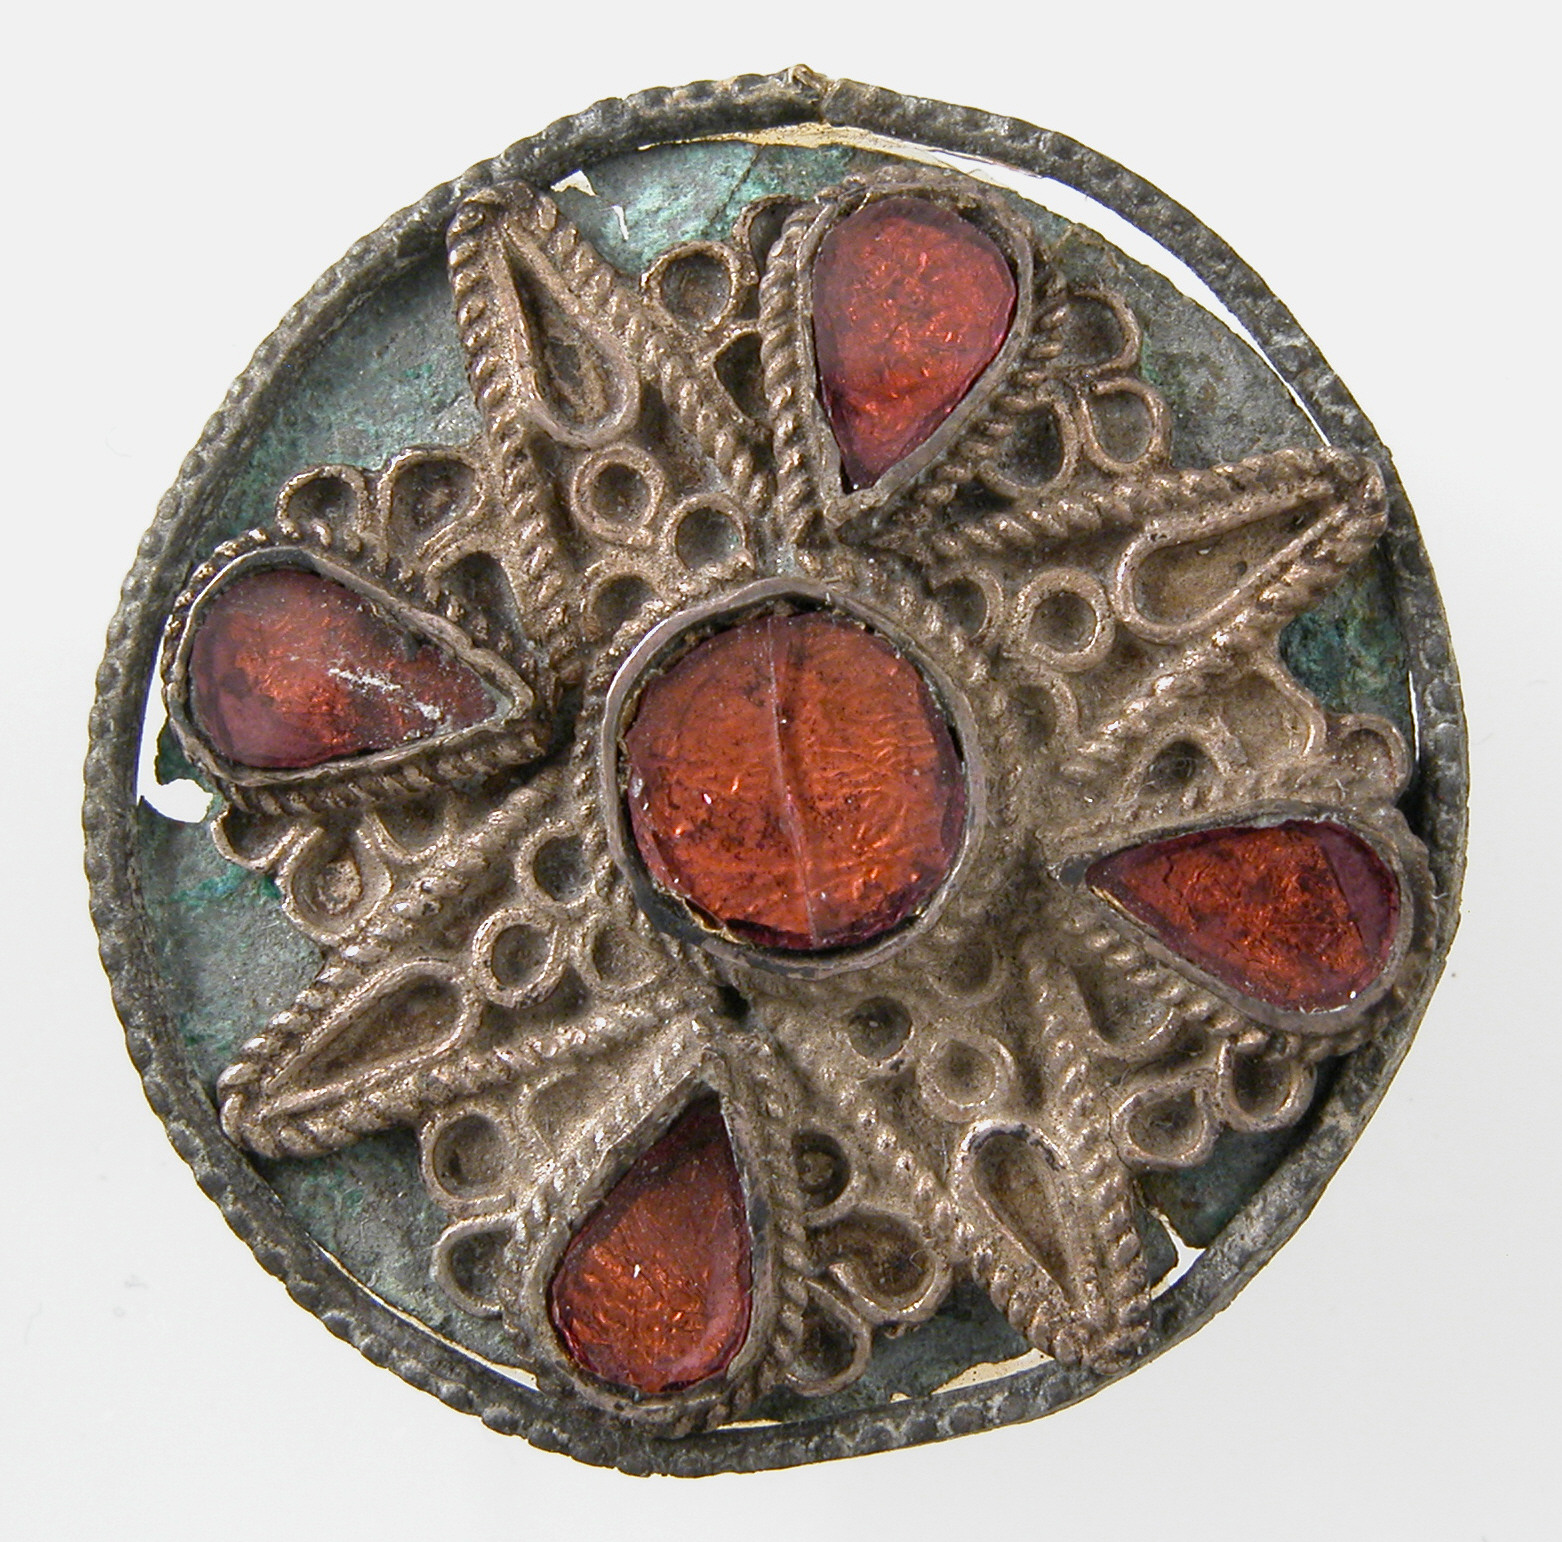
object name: brooch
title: Disk Brooch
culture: frankish or northern french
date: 550-600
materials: copper alloy, glass, iron, paste, silver, metal